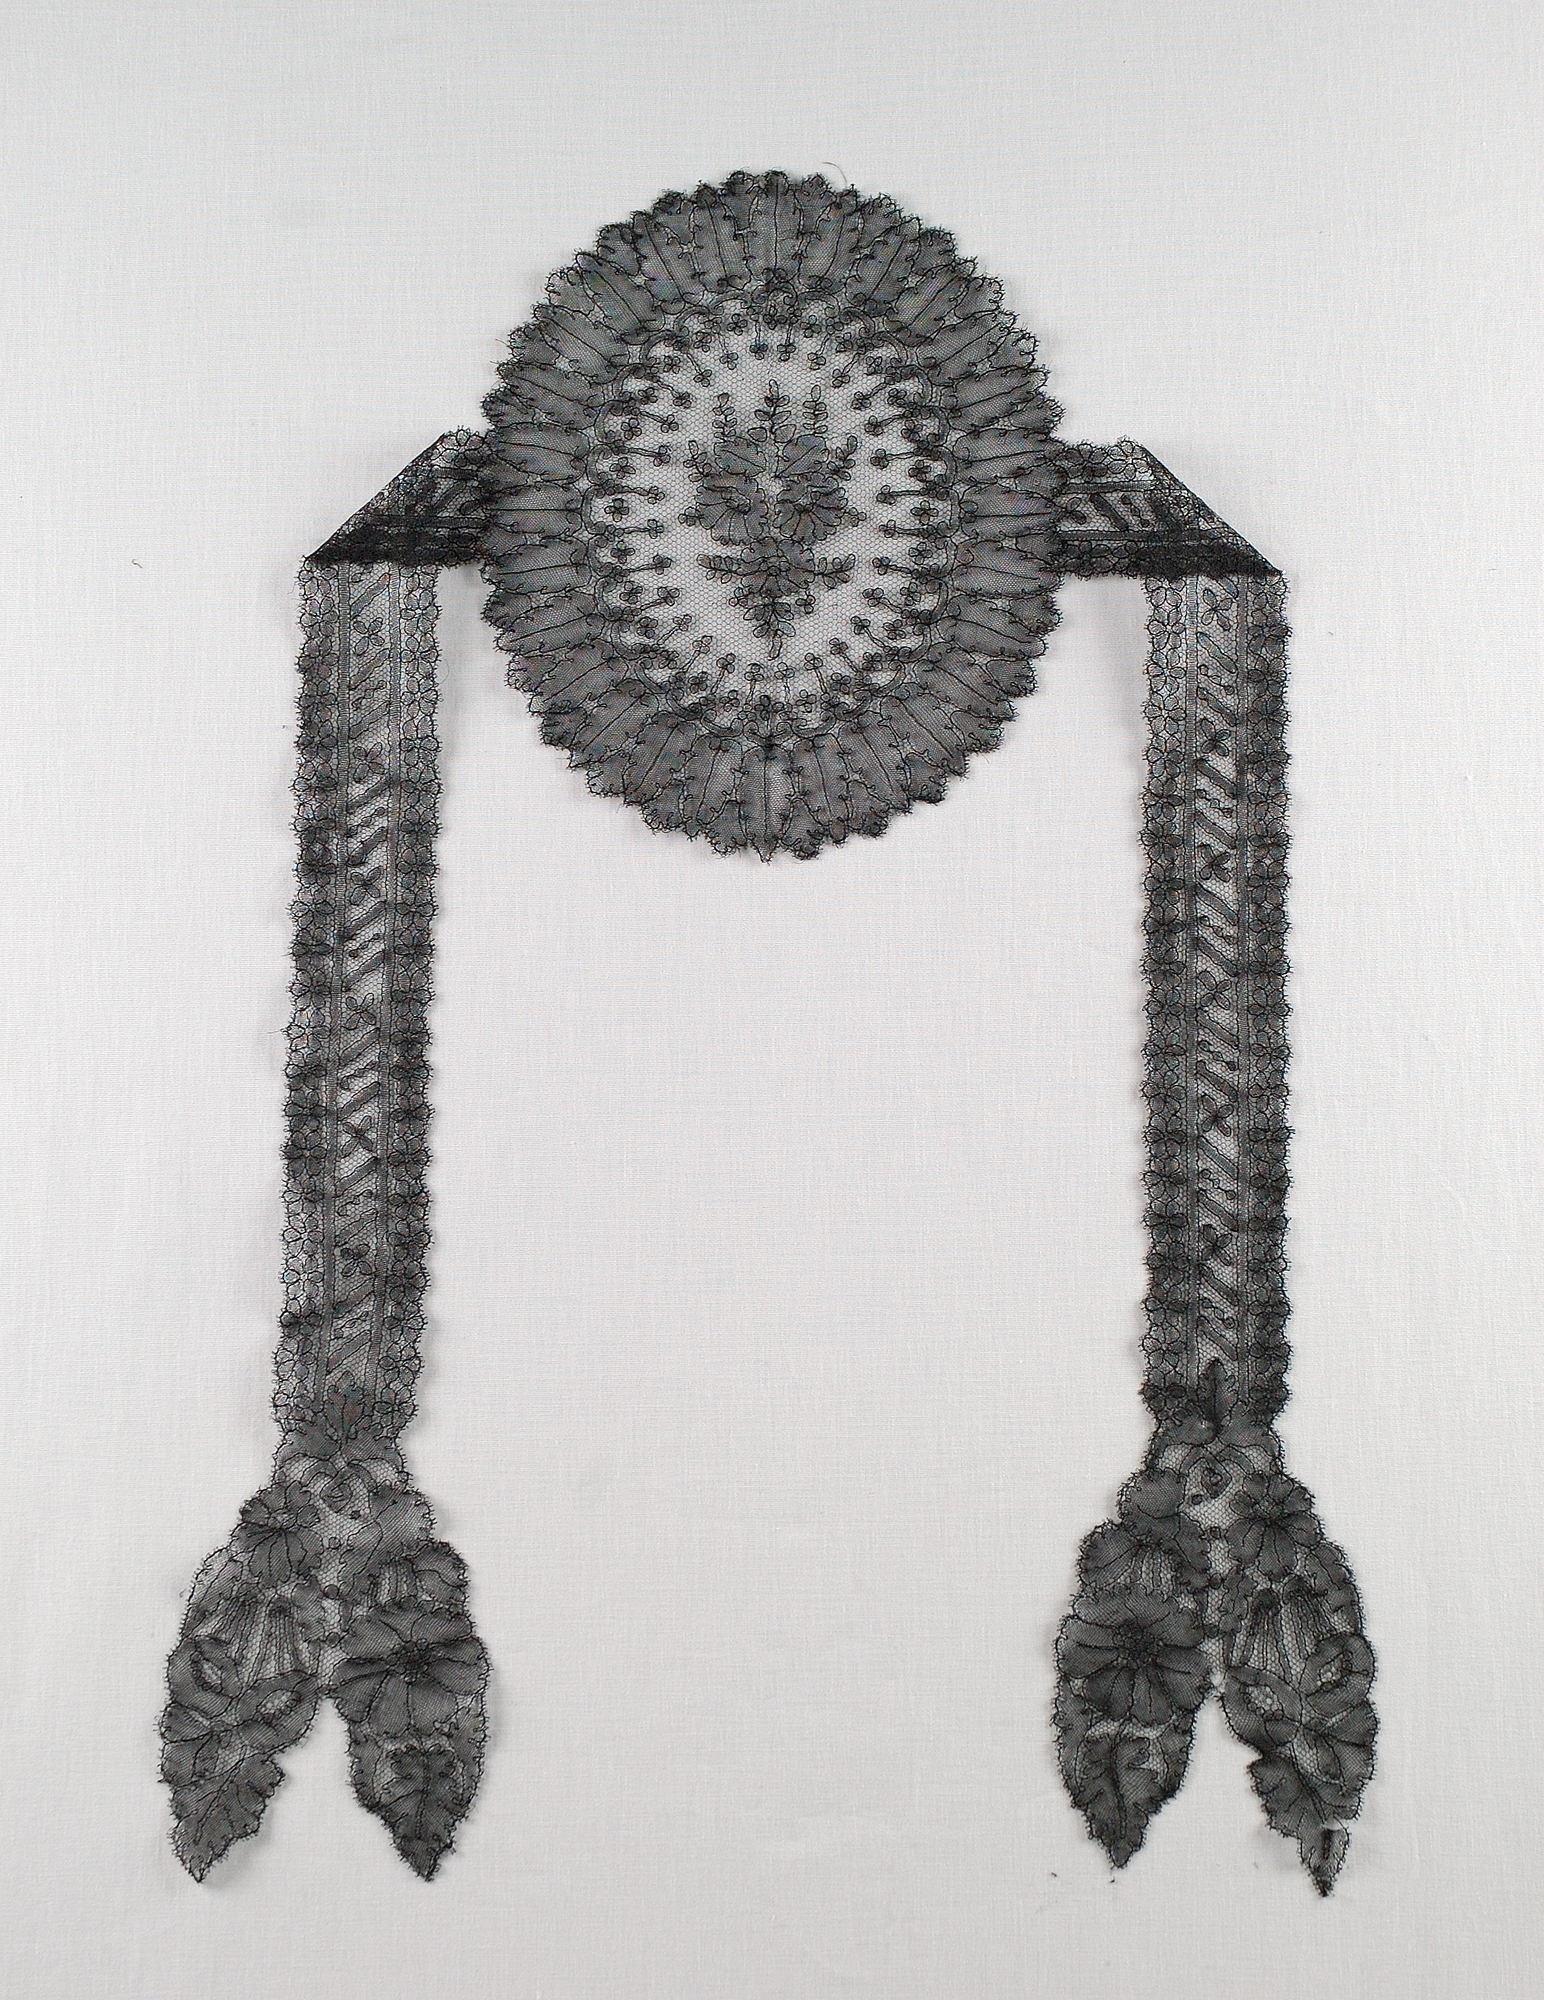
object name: fanchon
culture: french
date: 1868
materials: silk